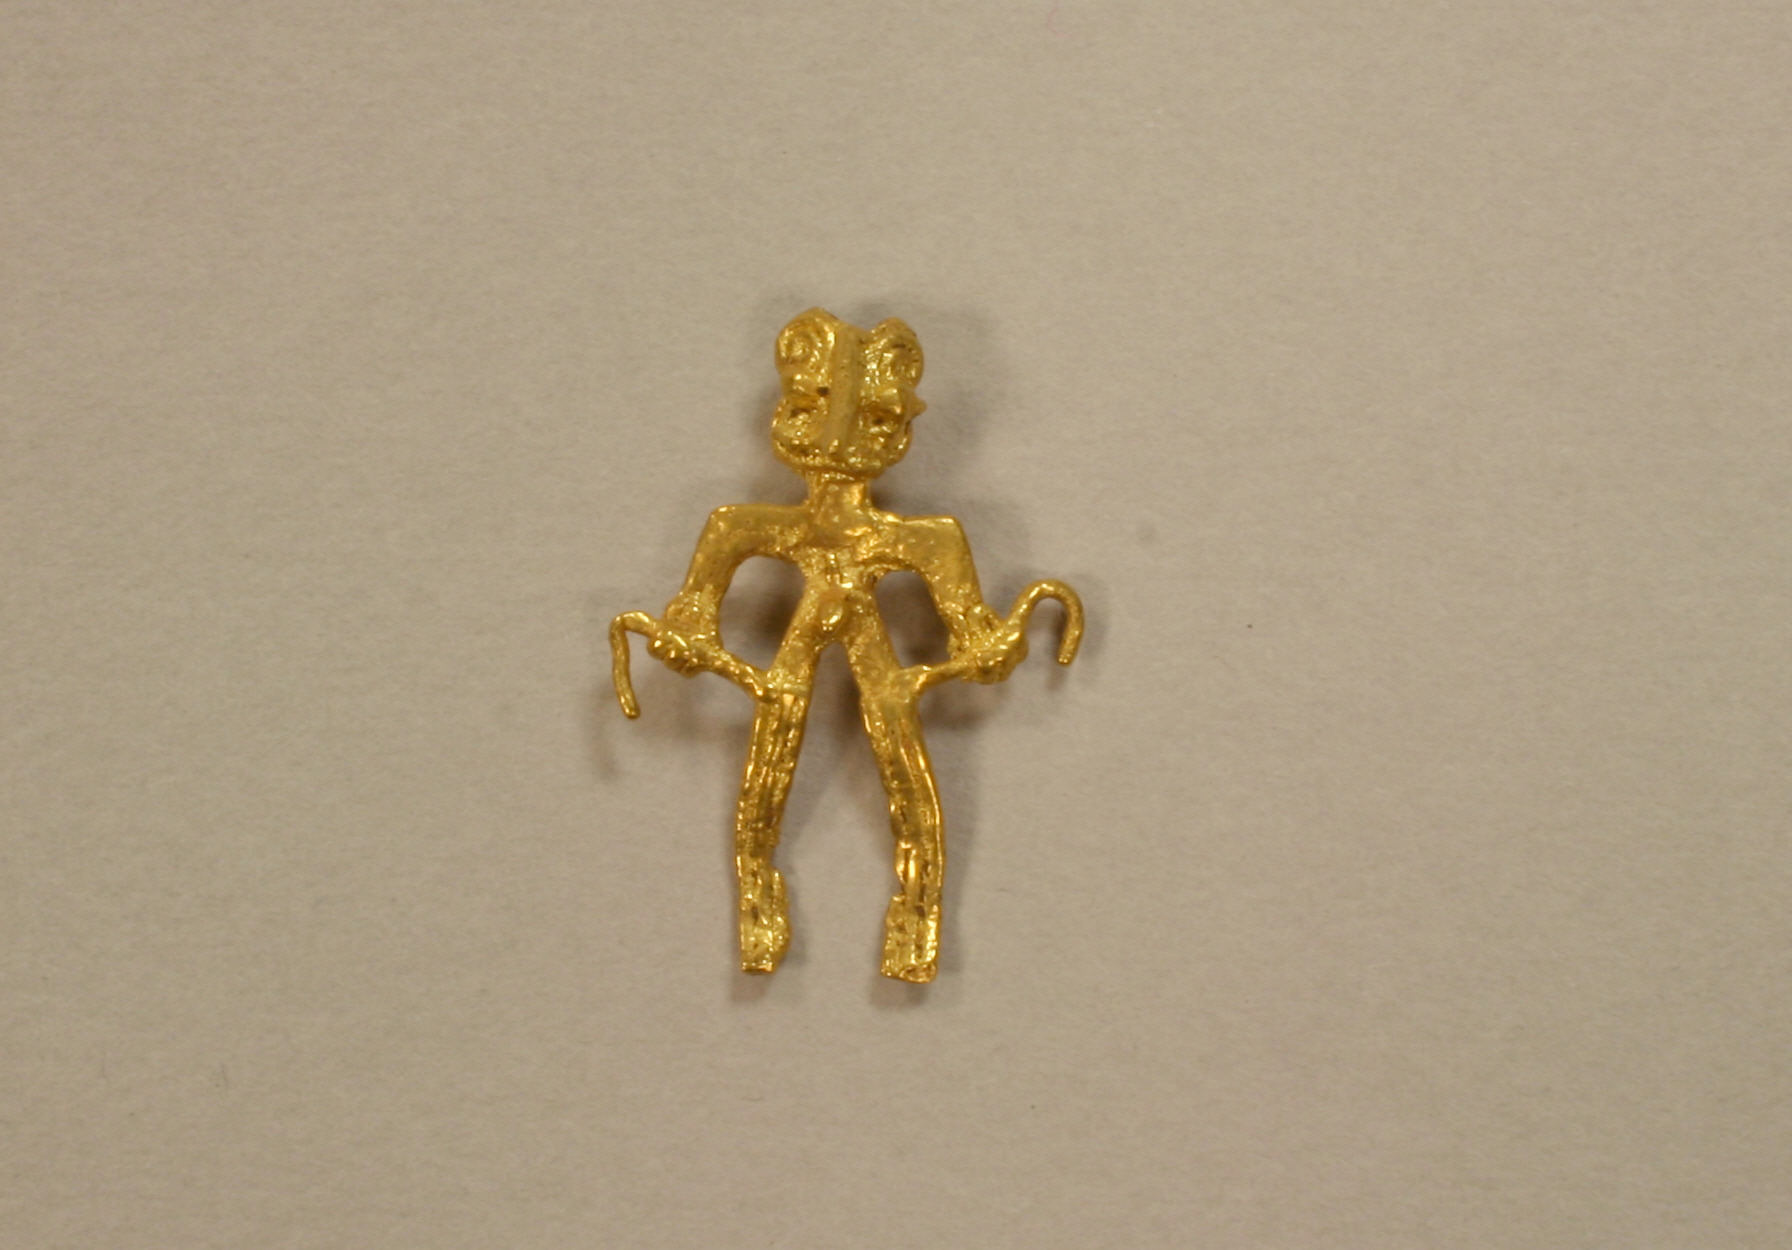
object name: pendant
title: Figure Pendant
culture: costa rican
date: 701-1600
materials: gold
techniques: casting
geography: costa rica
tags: human figures